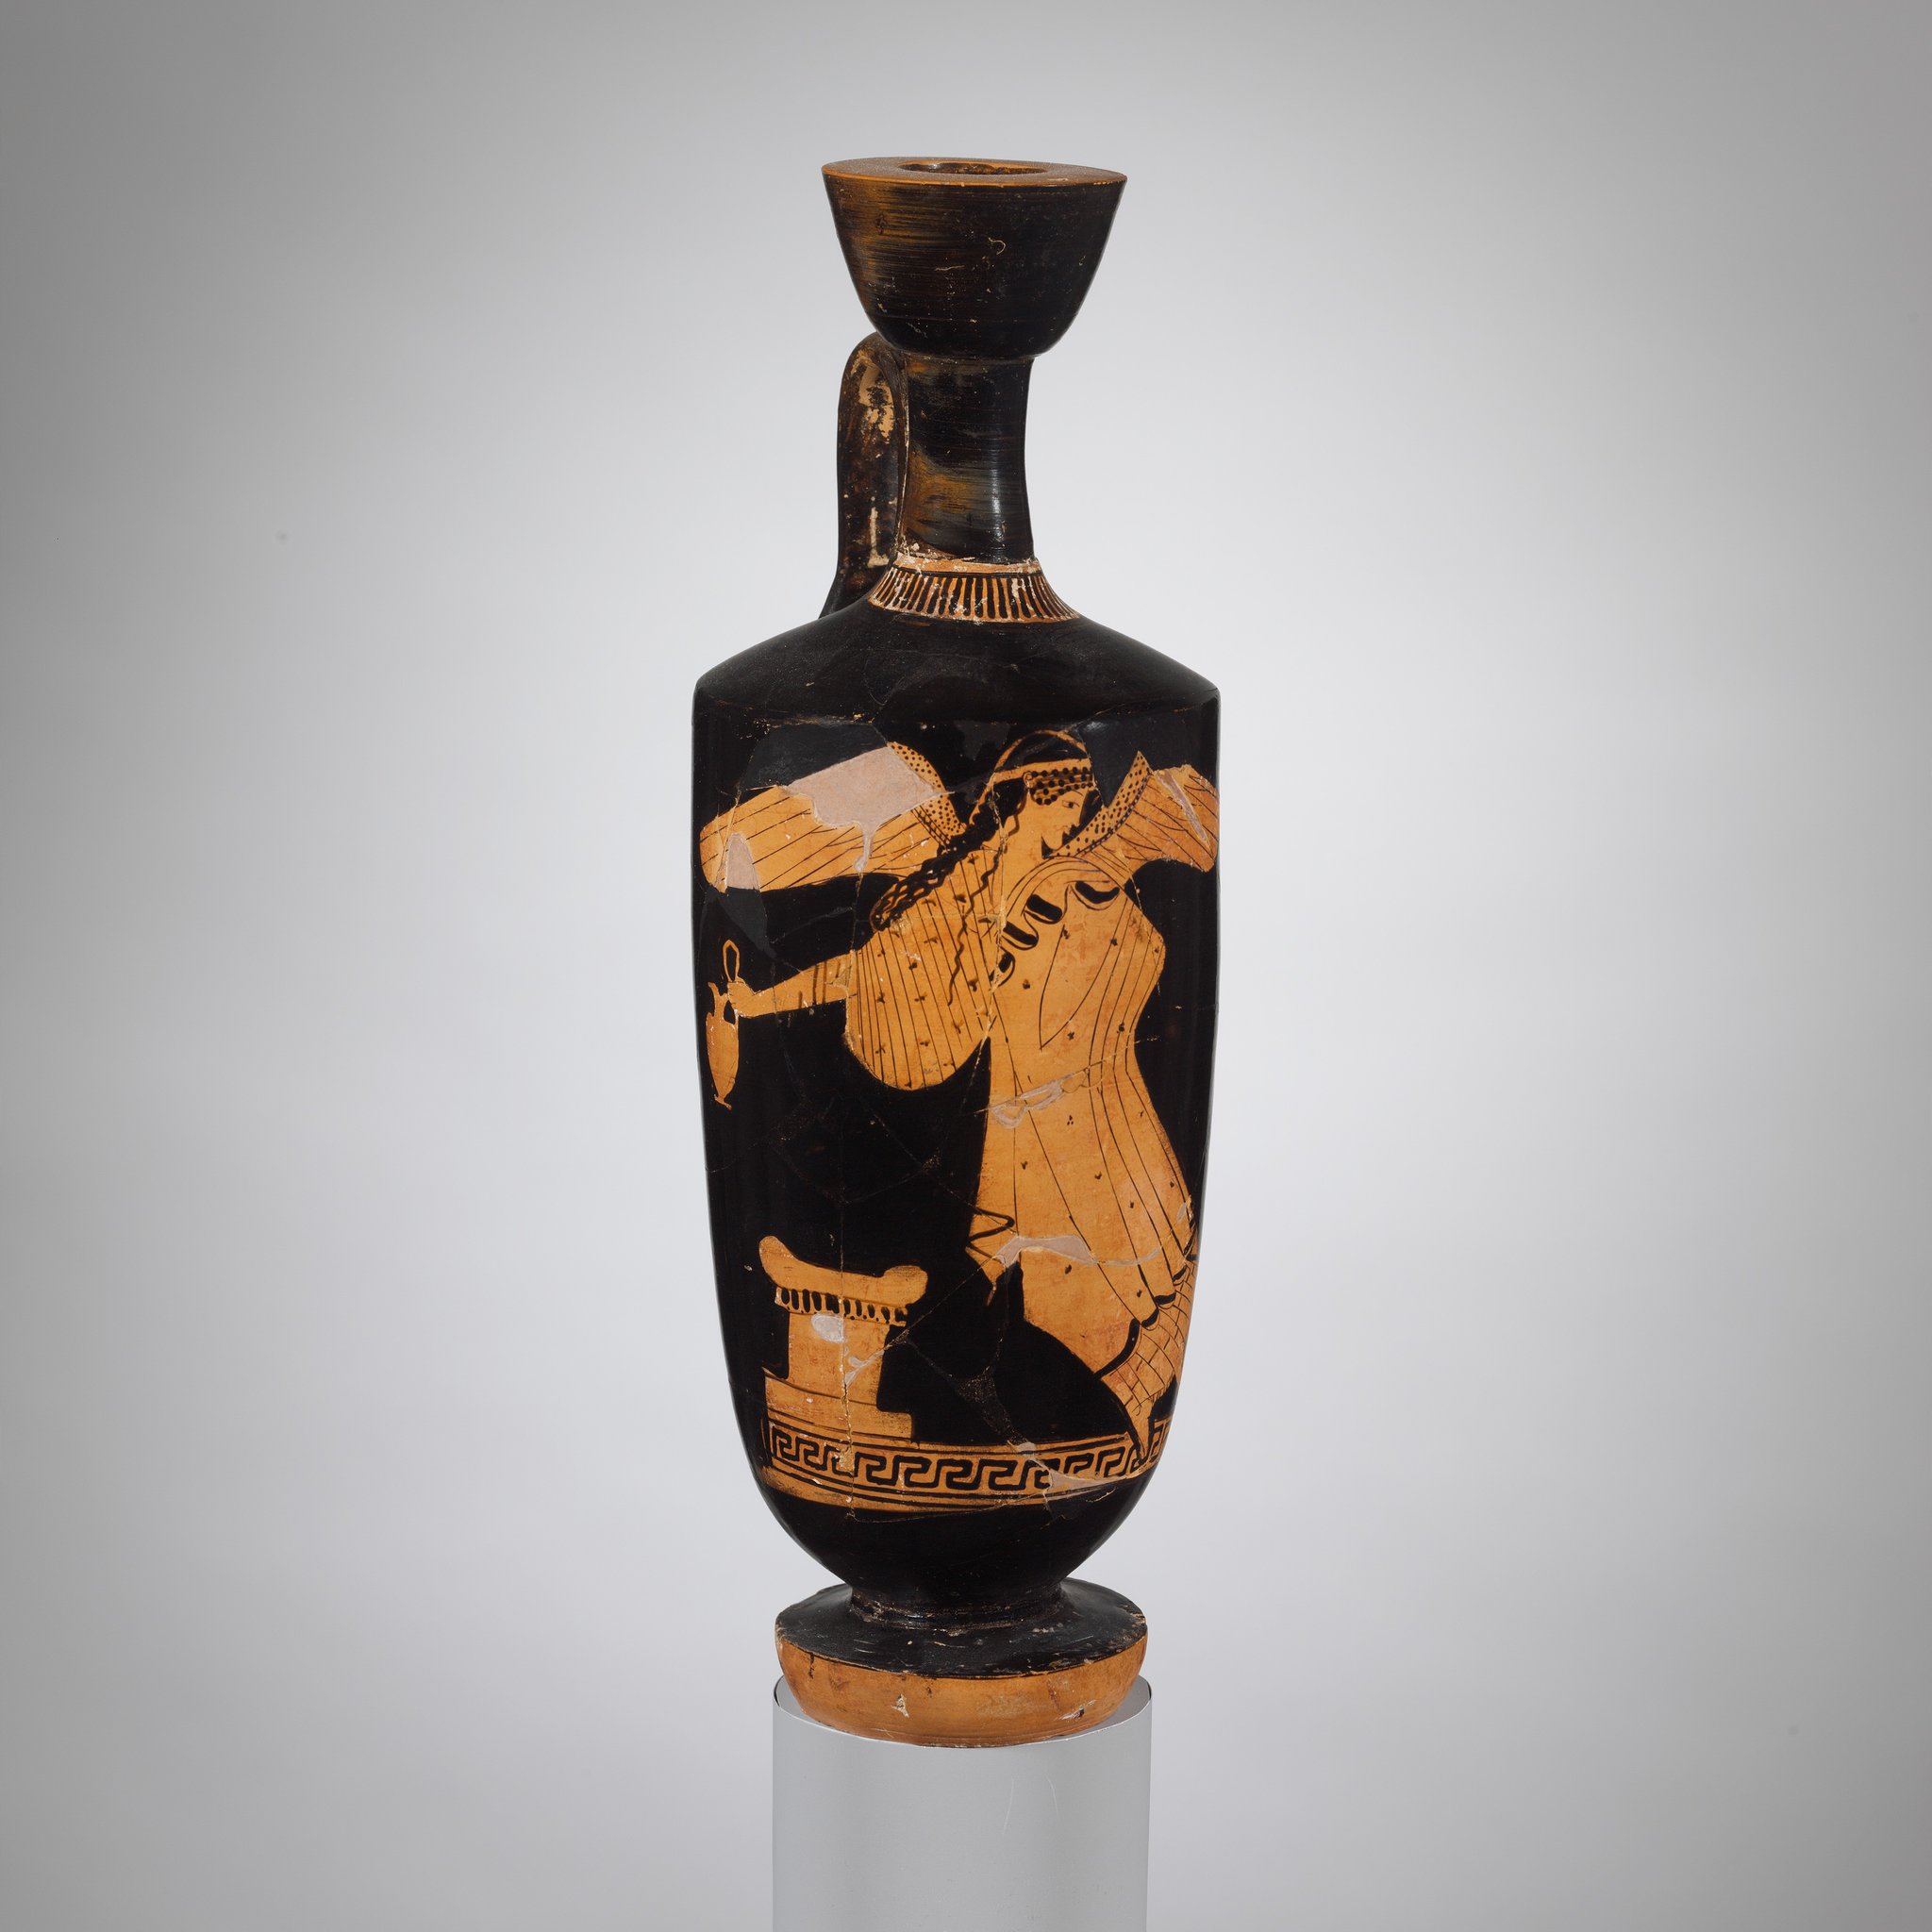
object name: lekythos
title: Terracotta lekythos (oil jar)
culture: greek, attic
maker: painter of palermo 4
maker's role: artist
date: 480-470 BCE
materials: terracotta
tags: altars,nike